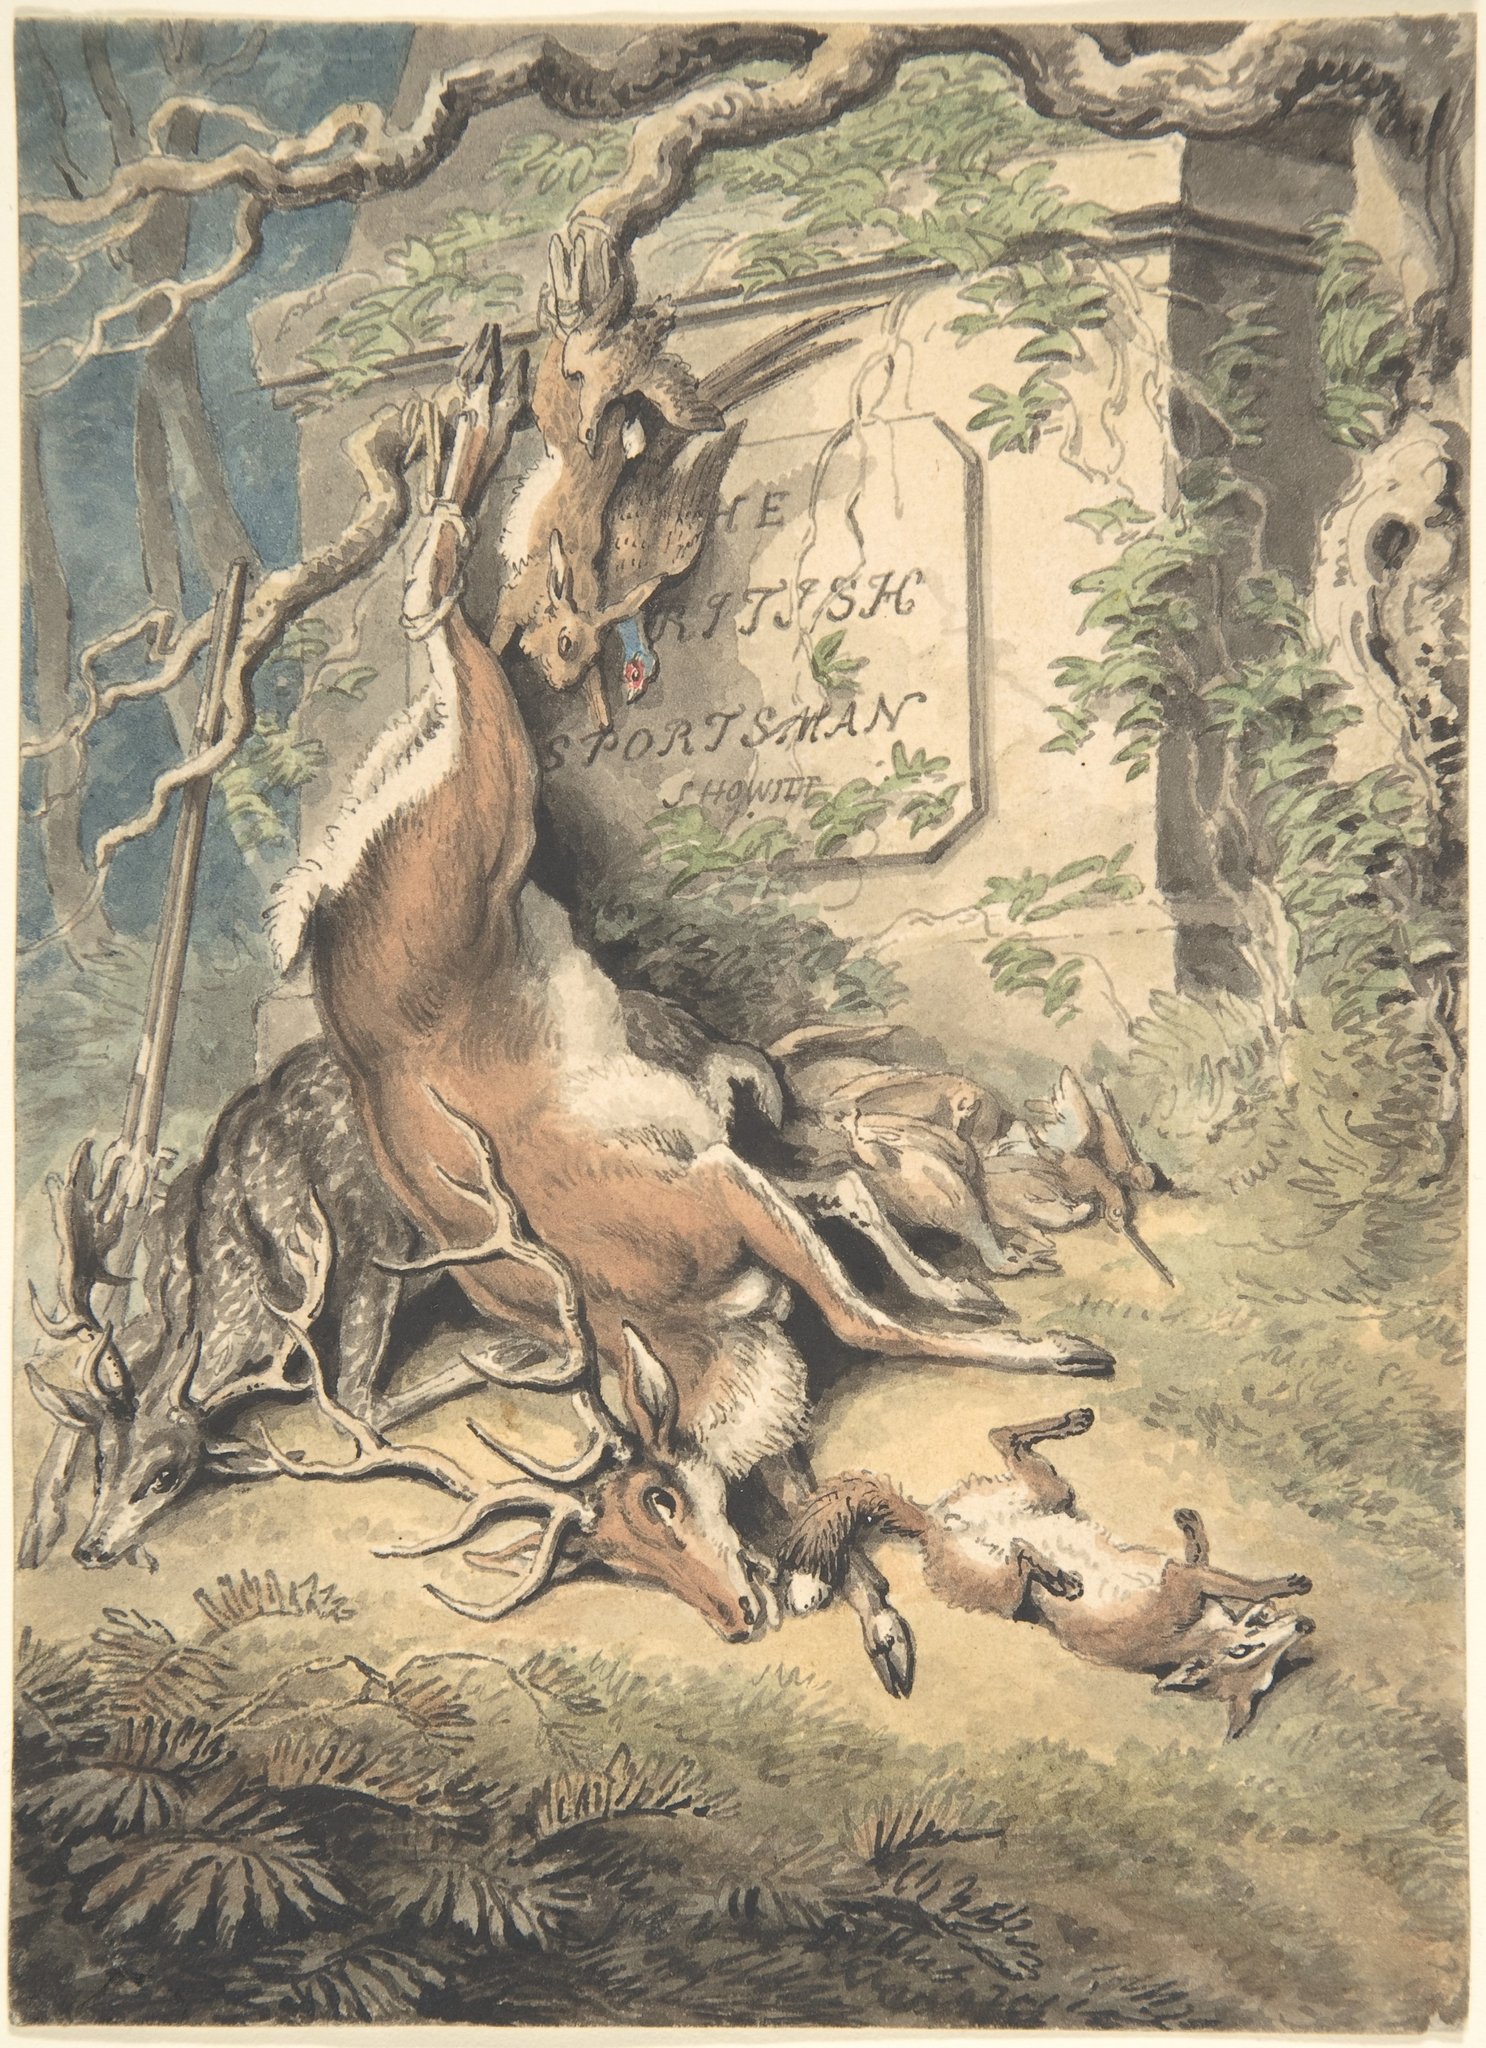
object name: drawing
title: Design for the Frontispiece of "The British Sportsman"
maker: samuel howitt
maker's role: artist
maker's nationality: british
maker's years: 1756-1823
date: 1767-1833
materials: watercolor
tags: deer,foxes,squirrels